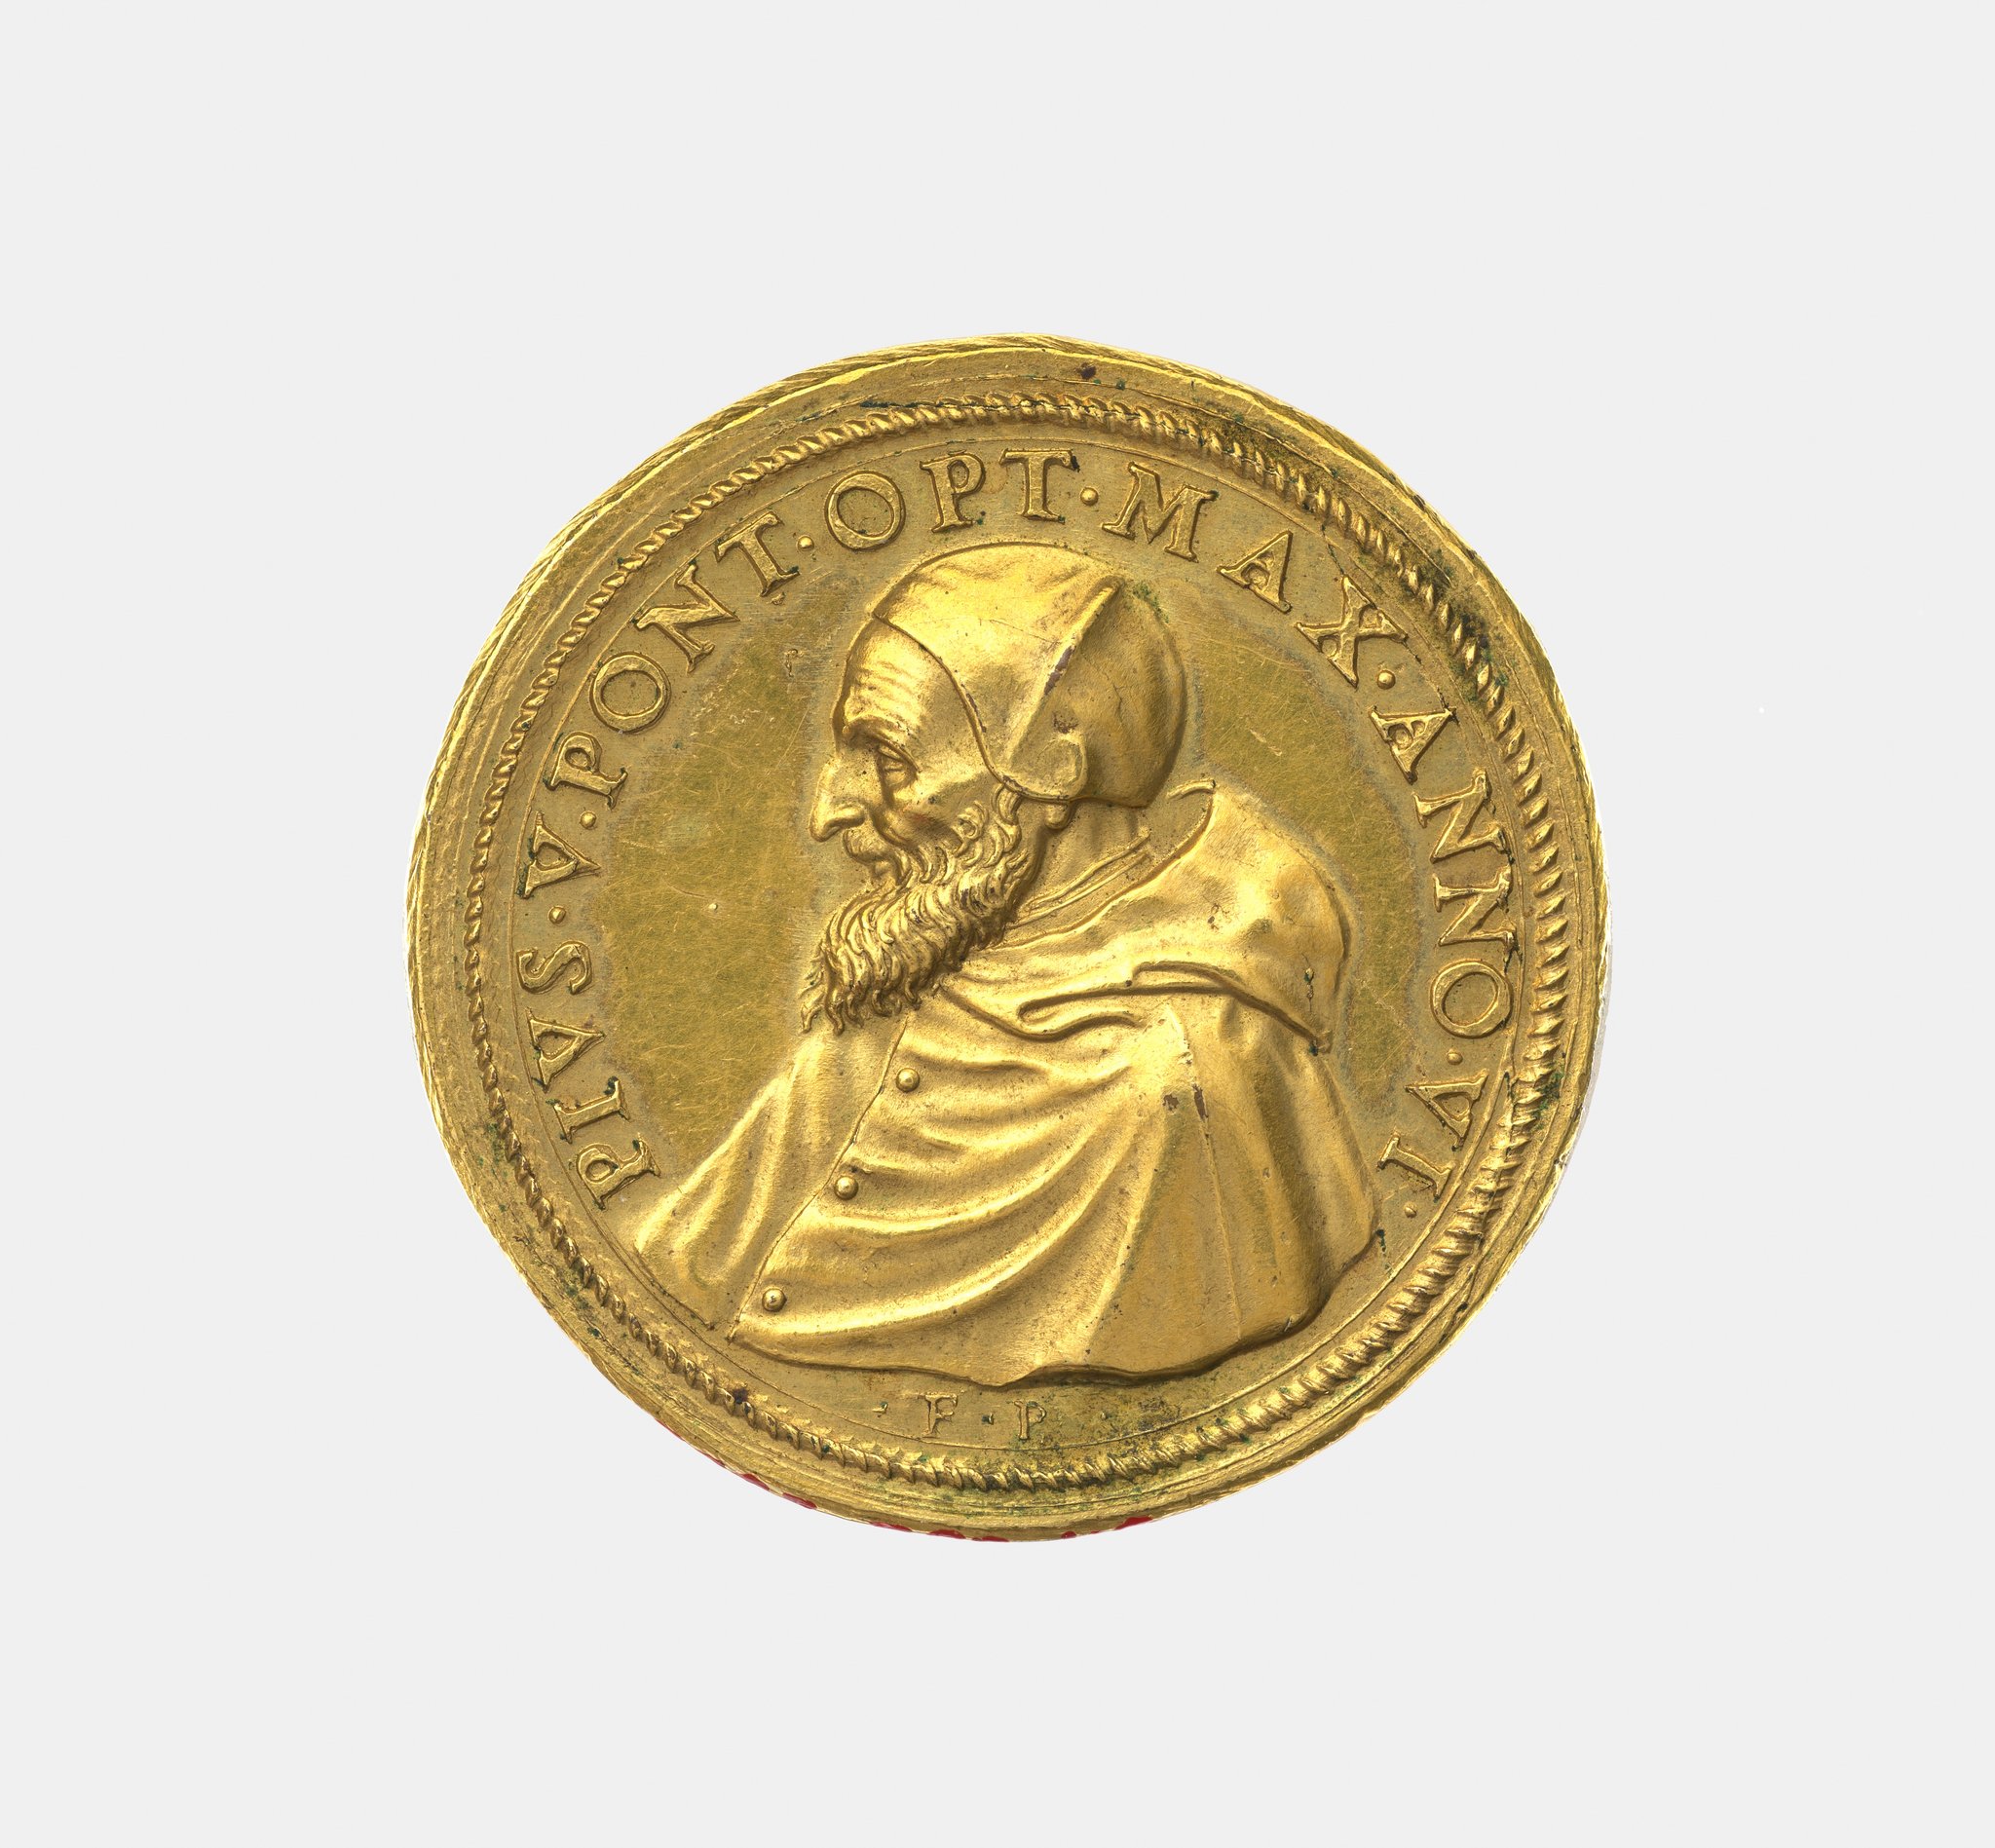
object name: medal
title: Pius V (Michele Ghislieri 1504-72) Pope 1566-72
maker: gian federigo bonzagna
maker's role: artist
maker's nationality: italian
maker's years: 1507-1588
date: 1571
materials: bronze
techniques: gilding